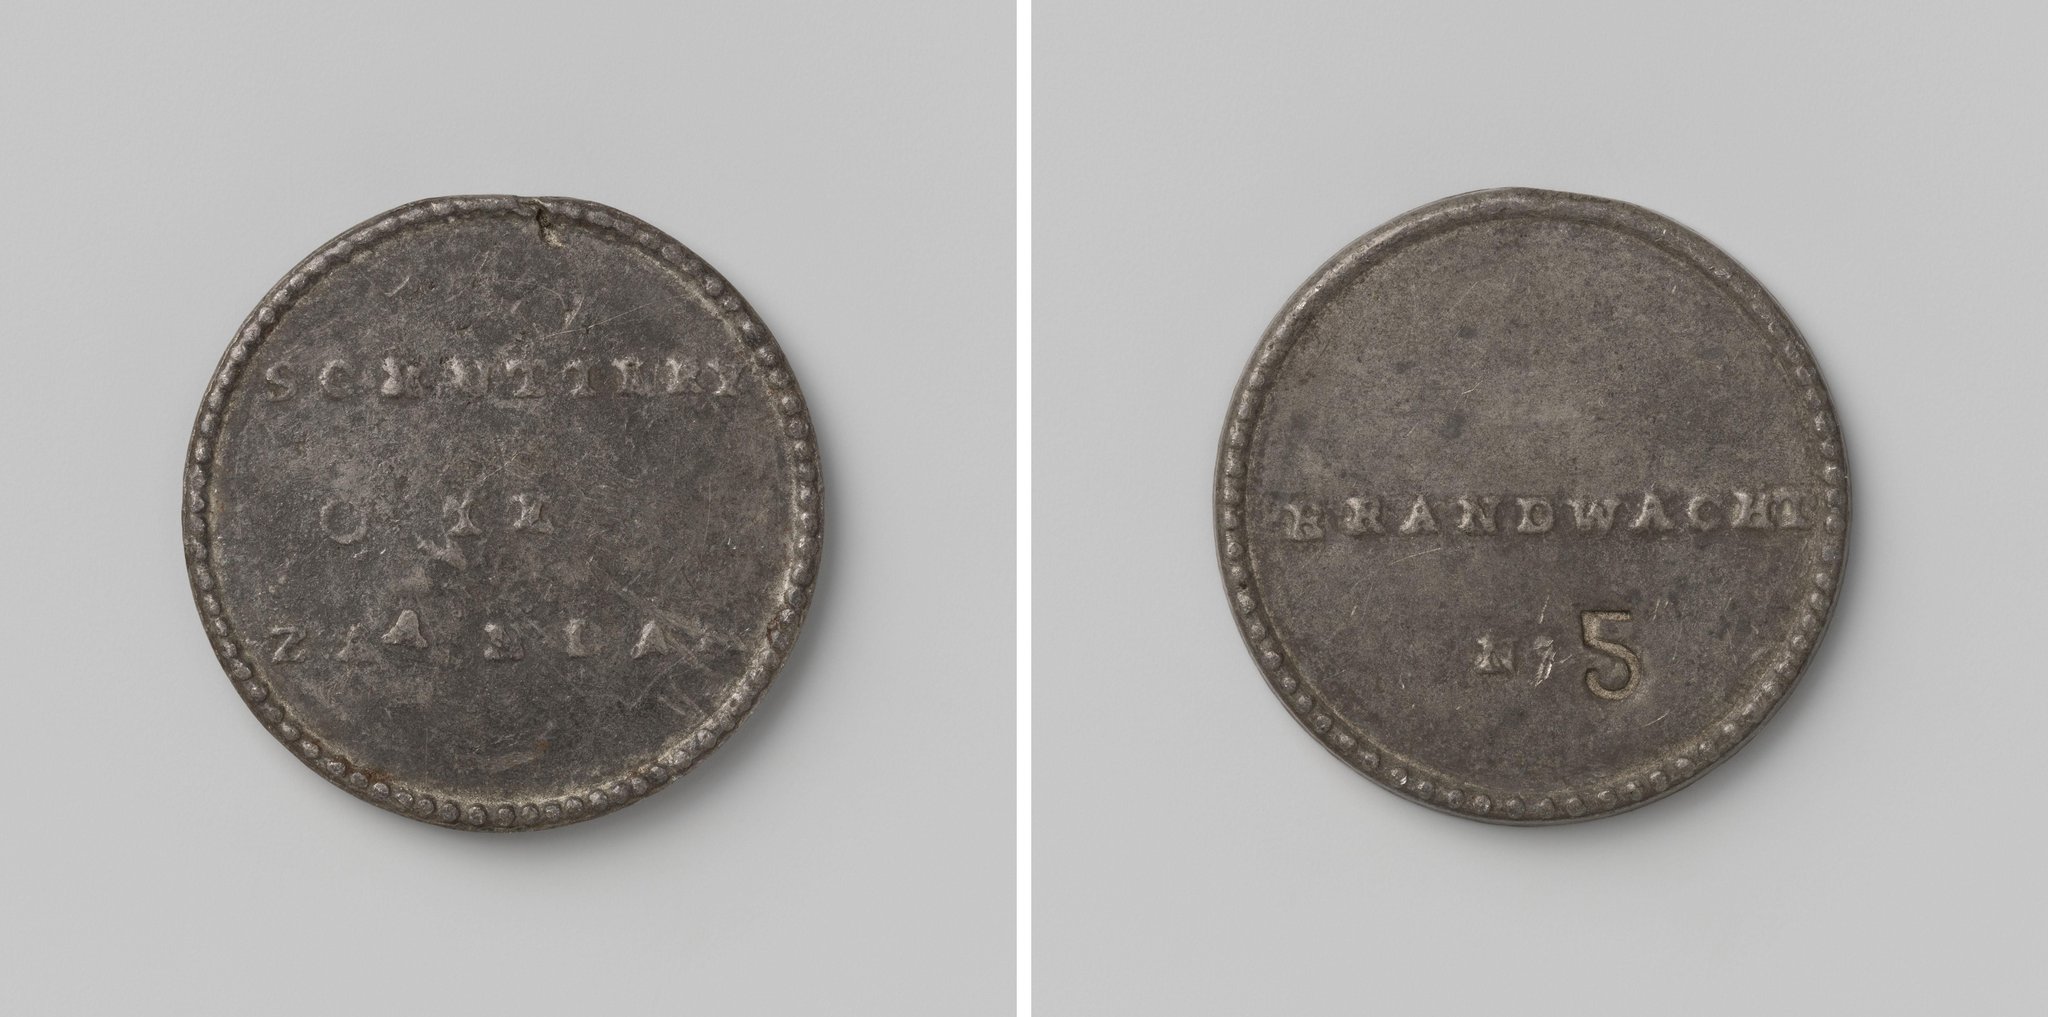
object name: medal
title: Zaandam, brandspuitpenning van brandwacht no. 5 van de schutterij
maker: Anonymous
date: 1680-1800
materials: lead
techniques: casting, engraving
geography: zaandam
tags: zaandam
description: Loden penning. Voorzijde: opschrift binnen parelrand. Keerzijde: opschrift boven cijfer No. 57 binnen parelrand